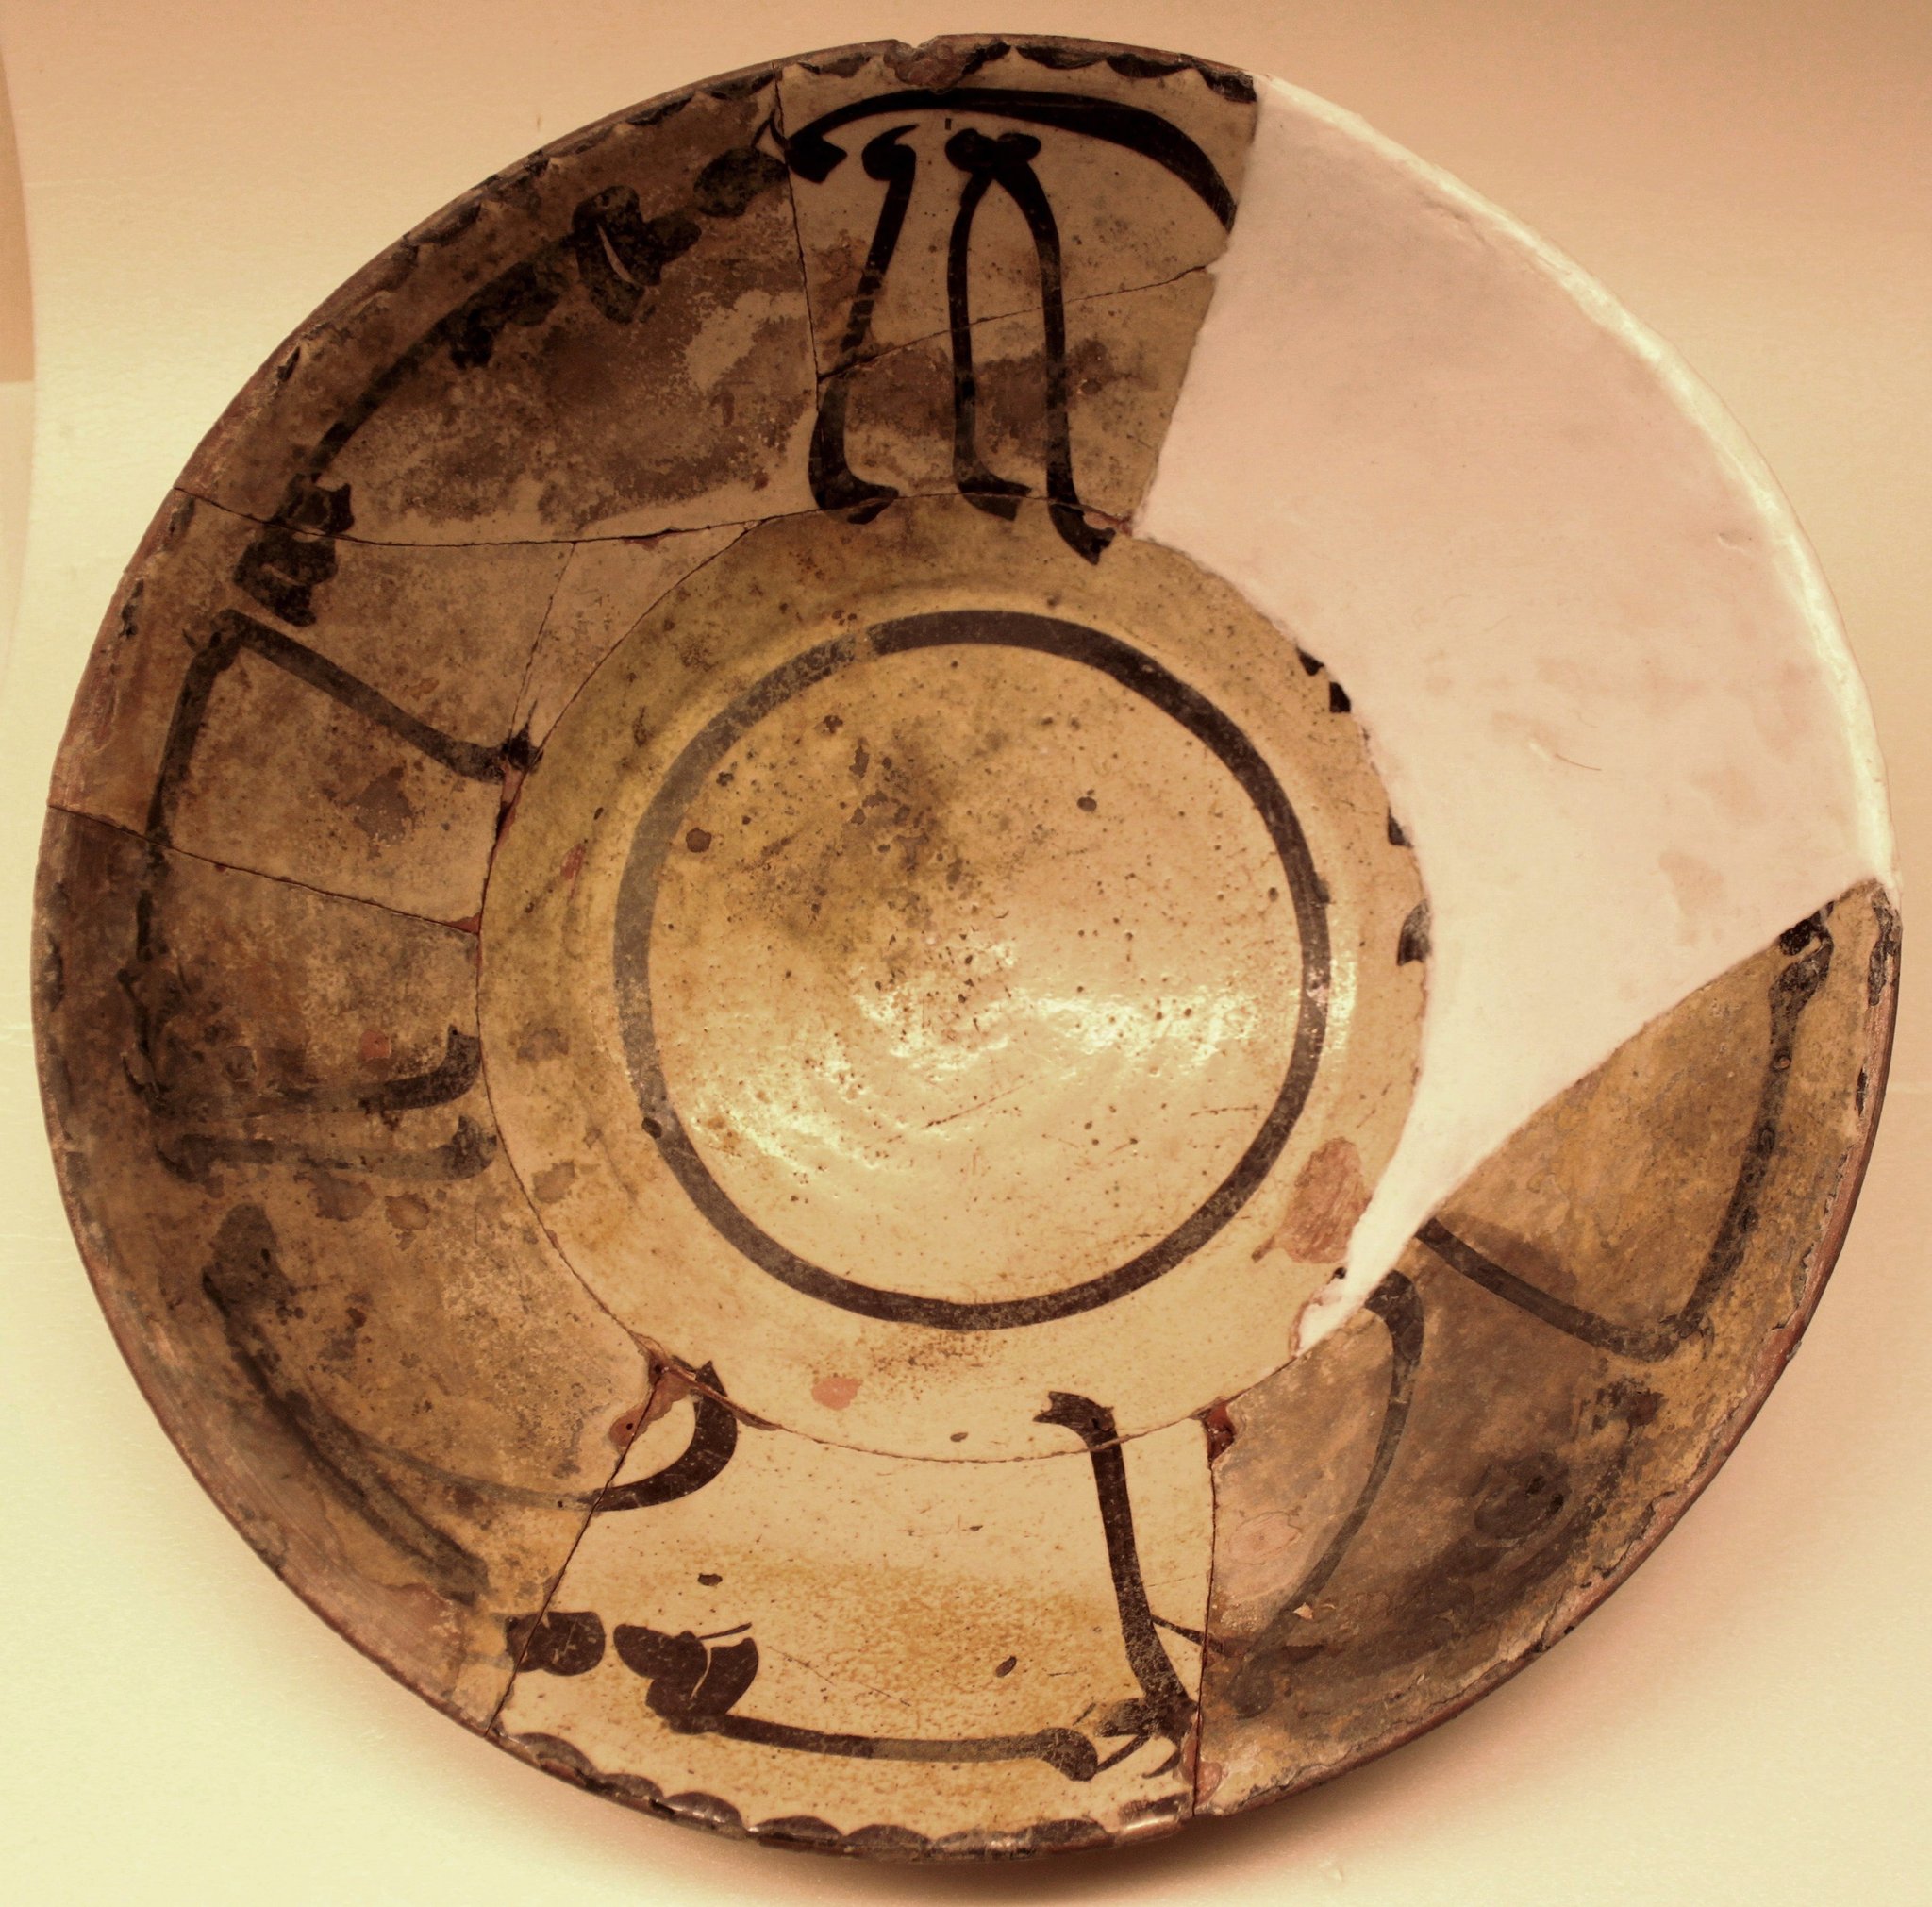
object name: bowl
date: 901-1000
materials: earthenware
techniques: glazing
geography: iran